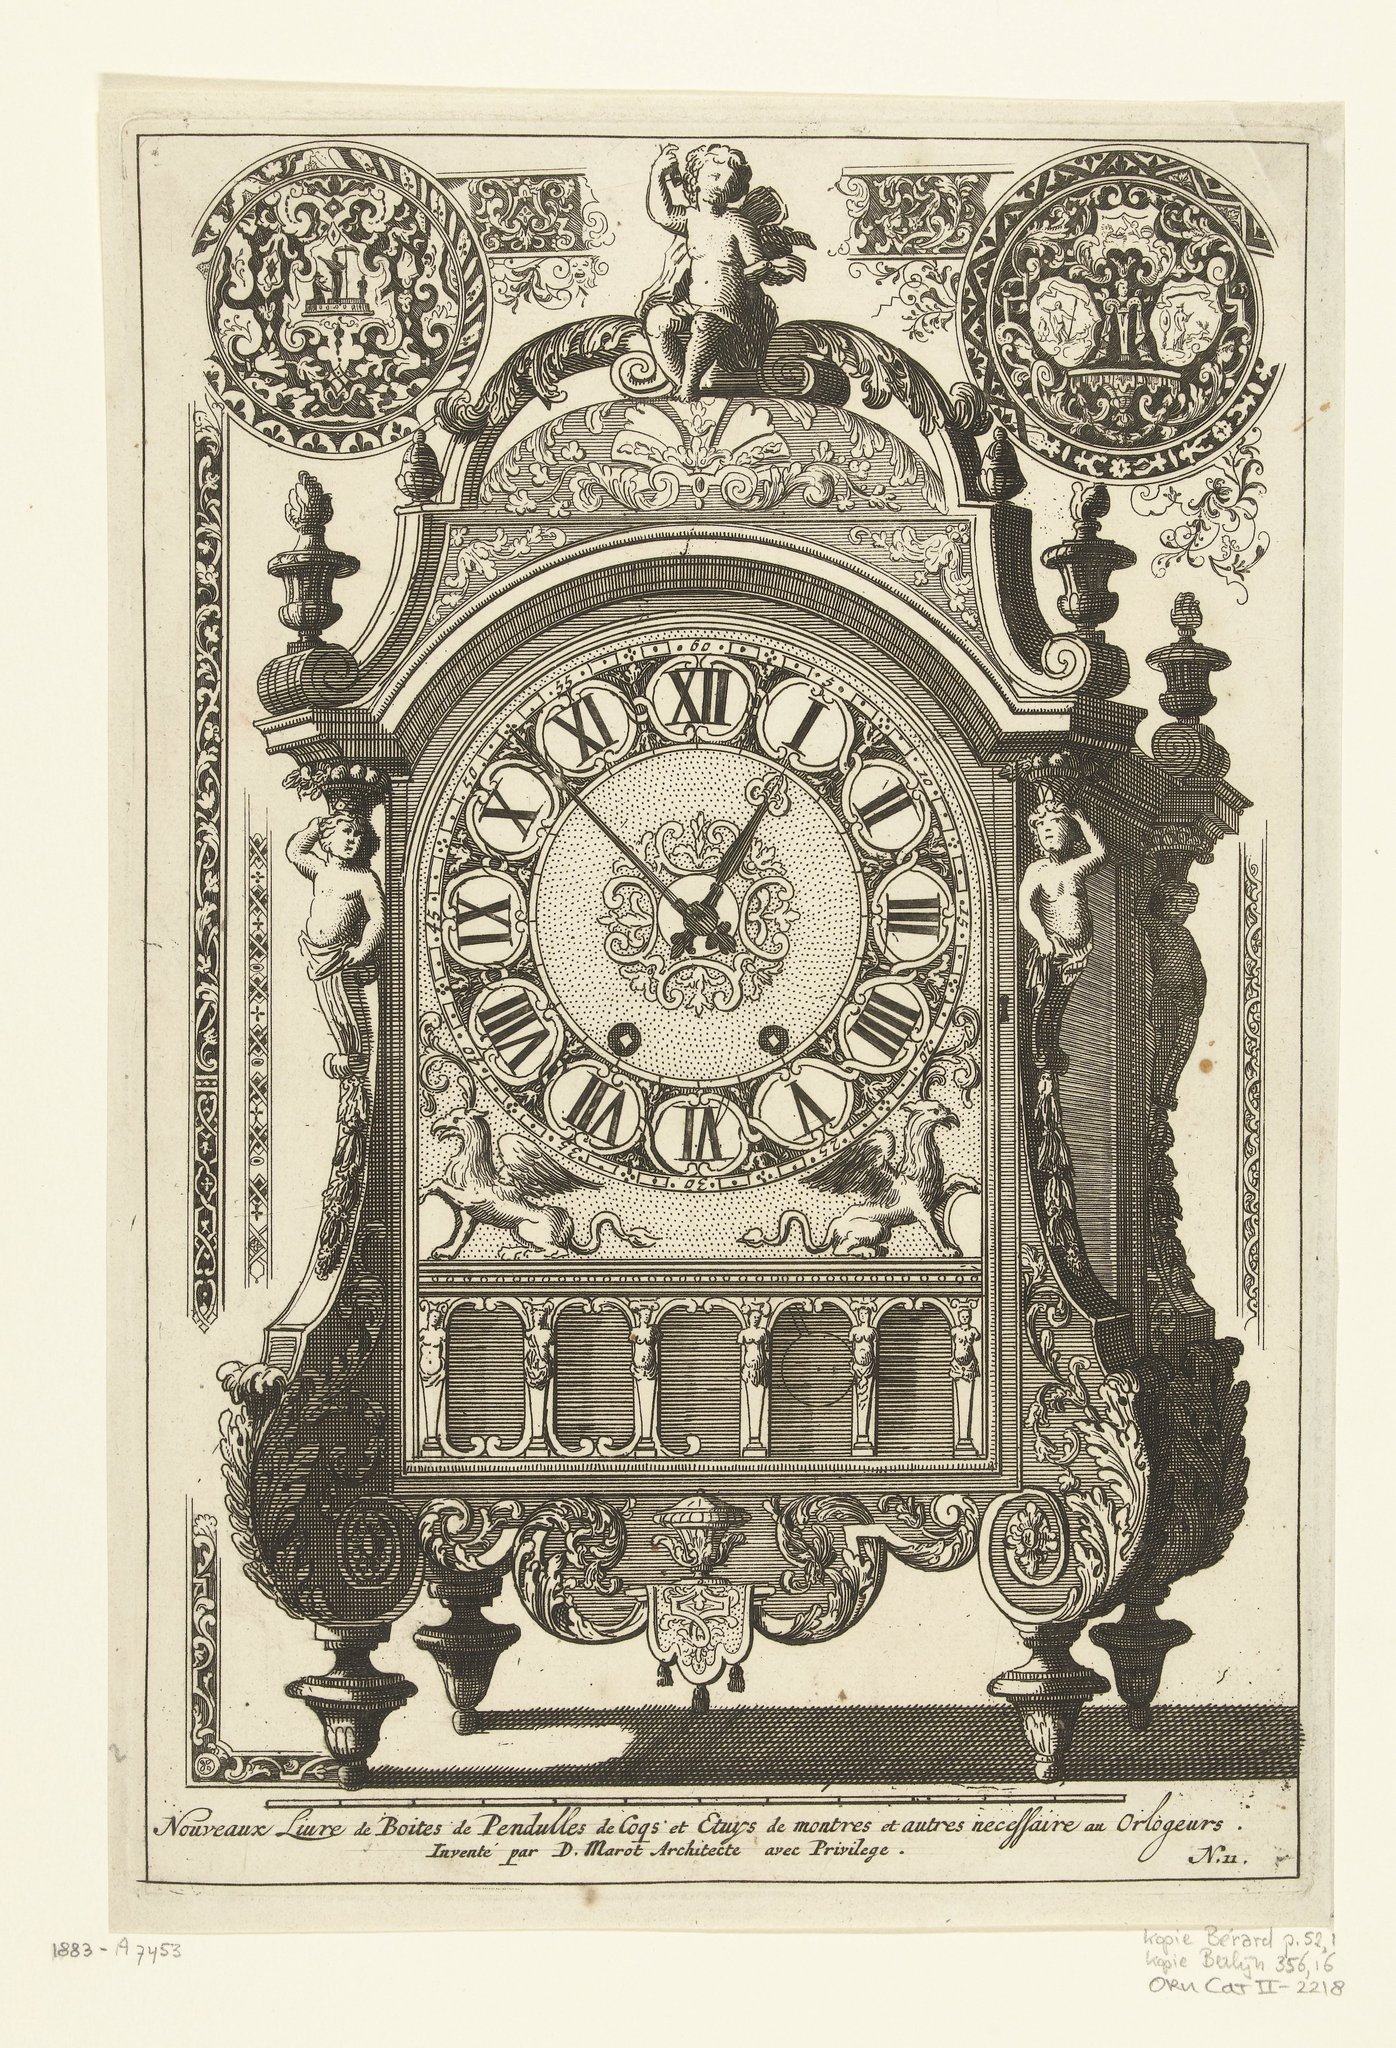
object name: ornament print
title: Nouveaux Liure de Boites de Pendulles de Coqs et Etuys de montres et autres necessaire au Orlogeurs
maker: Anonymous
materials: paper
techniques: etching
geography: netherlands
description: Pendule bekroond met een putto. Rechtsonder staat: N.11. Kopie van titelblad uit de serie Nouveaux Liure de Boïtes de Pendulles, uitgegeven door Daniel Marot omstreeks 1706. Blad uit tweede editie.